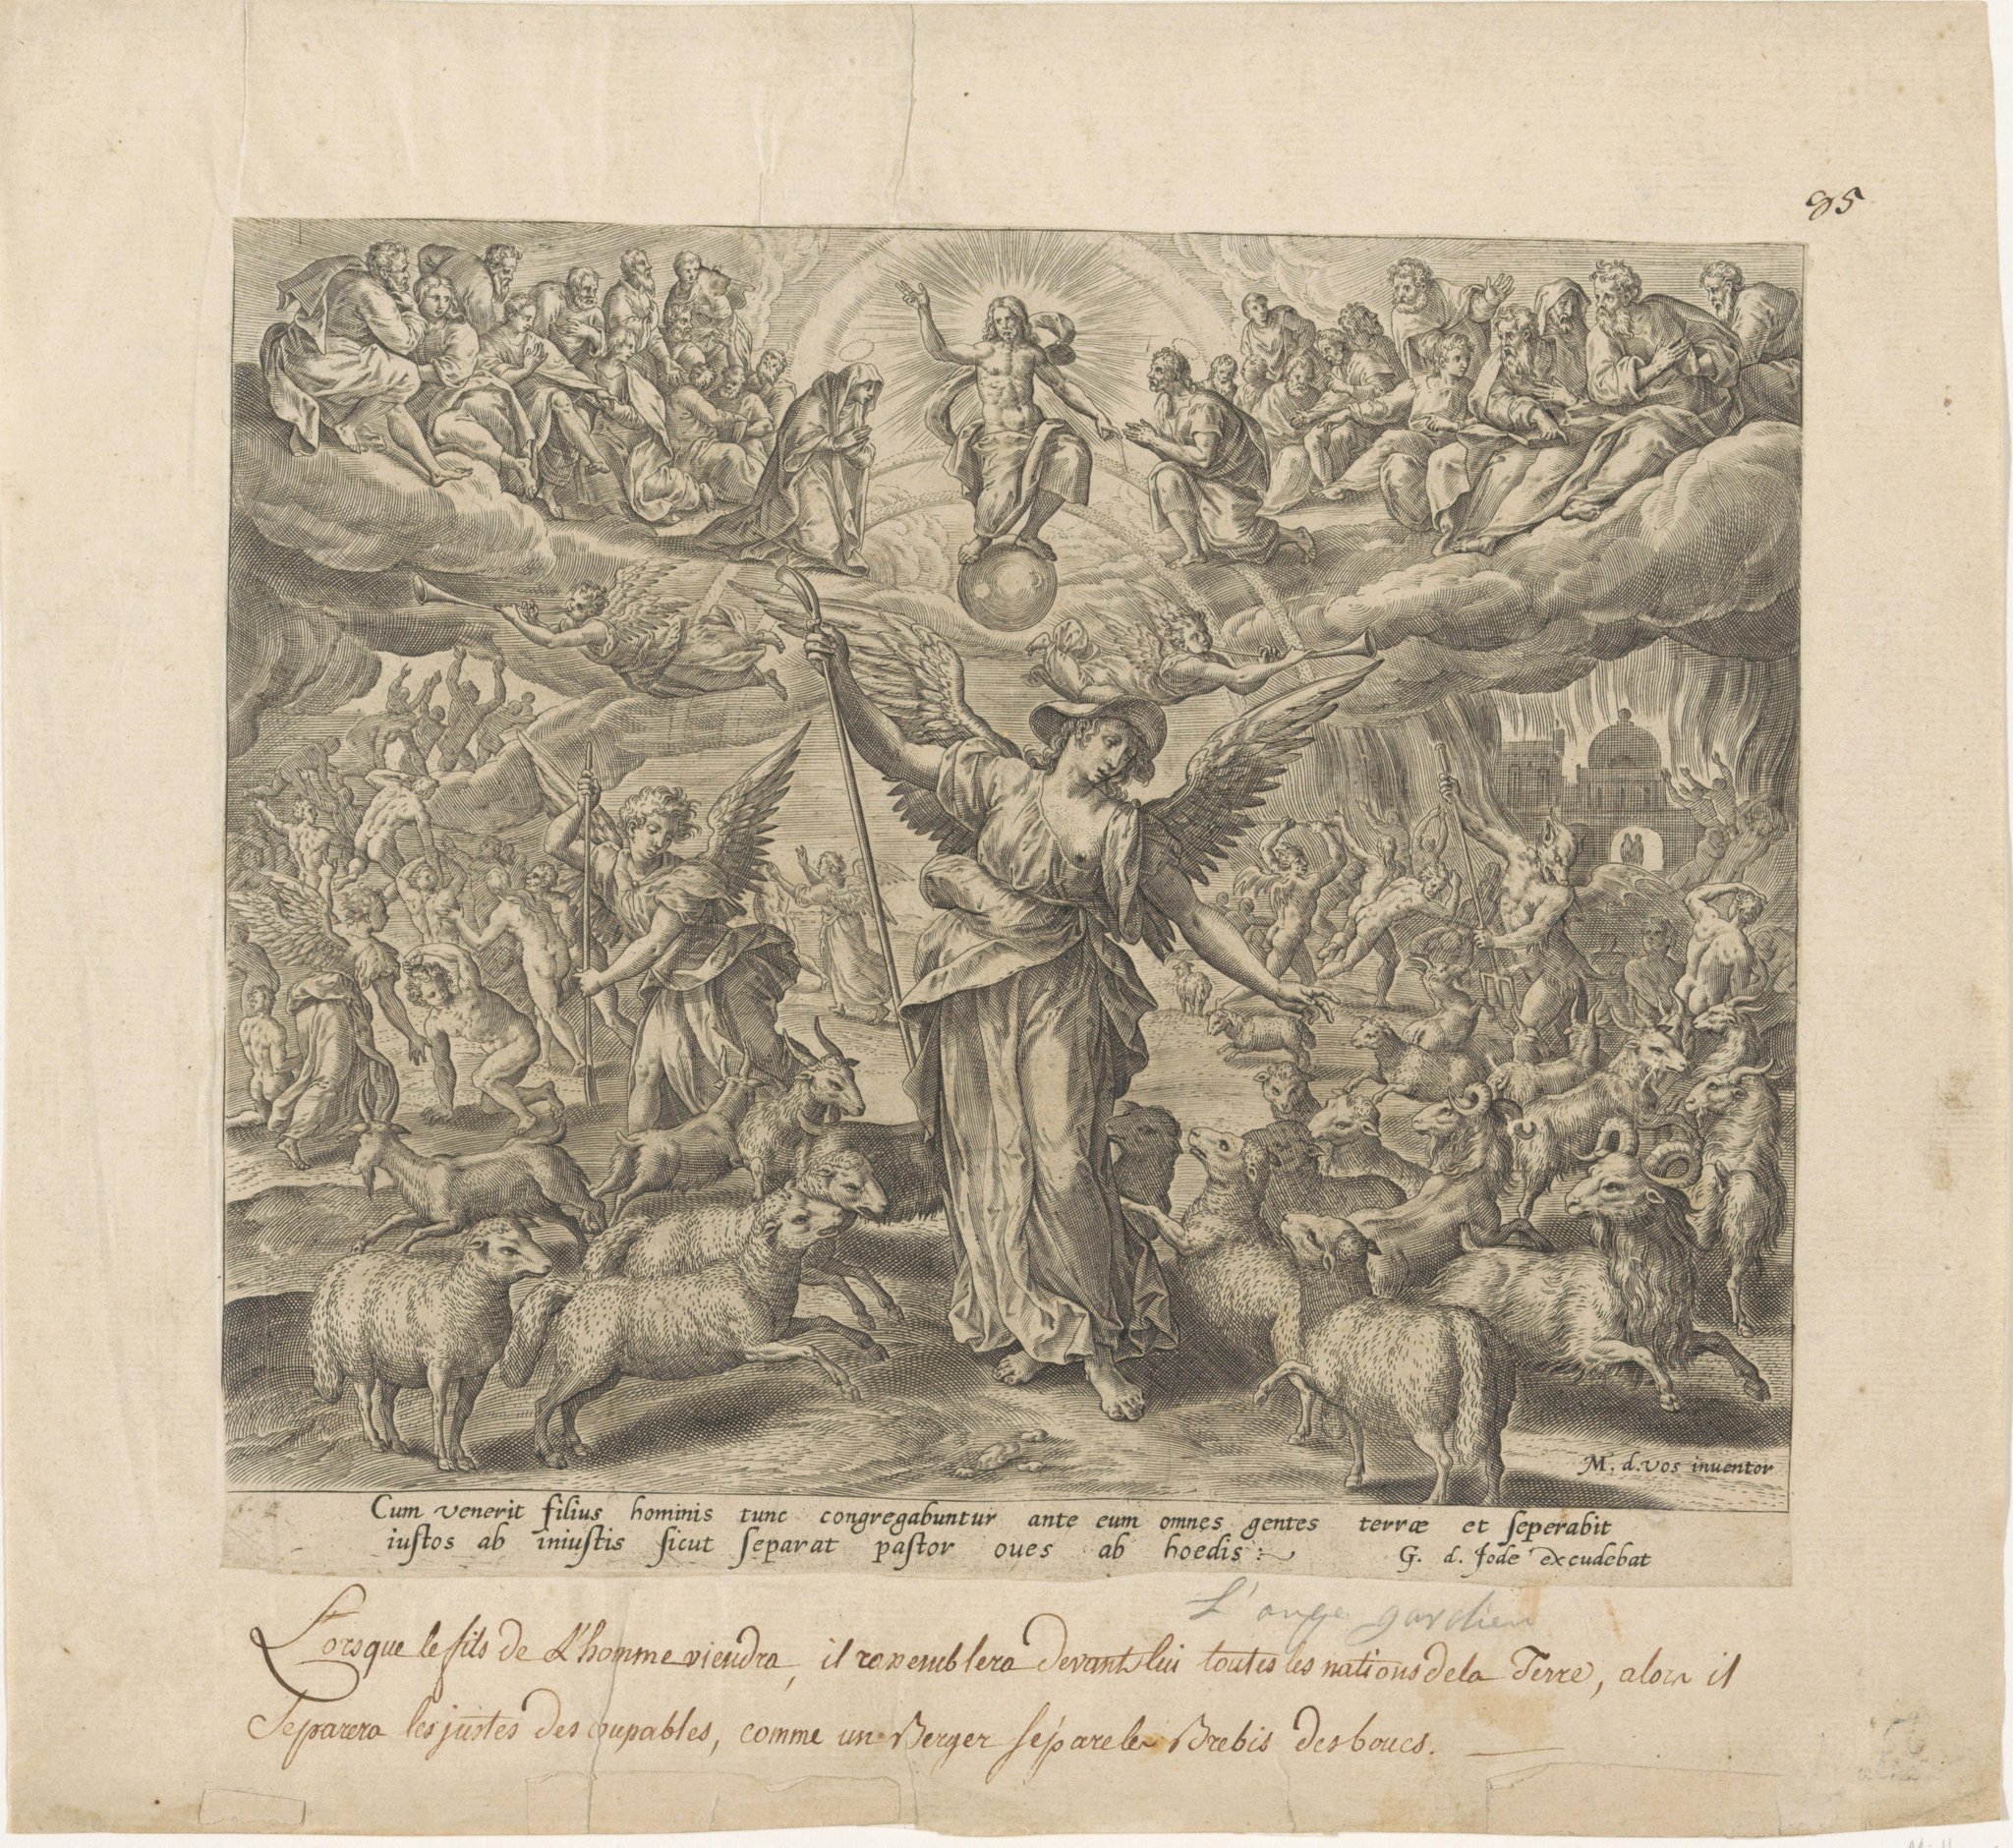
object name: print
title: Thesaurus sacrarum historiarum veteris testamenti (...)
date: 1585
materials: paper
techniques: engraving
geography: antwerp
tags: 'as a shepherd (the son of man) separates the sheep from the goats' (matthew 25:32), representation of last judgement, with the archangel michael weighing the souls (or dividing the blessed and the damned)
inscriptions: number: ‘85’, inscription: ‘Lorsque le fils de l'homme viendra, il rassemblera devant lui toutes les nations de la terre, aloin il separera les justes des coupables, comme un berger separe le brebis des boucs.’, collector's mark: Lugt 2228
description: De aartsengel Michael scheidt de schapen van de bokken. Christus troont op de wolken, geflankeerd door Maria en Johannes. De doden worden door engelen naar de hemel geleid (links) of naar de hel gevoerd (rechts). Onder de voorstelling een verwijzing in het Latijn naar de Bijbeltekst.